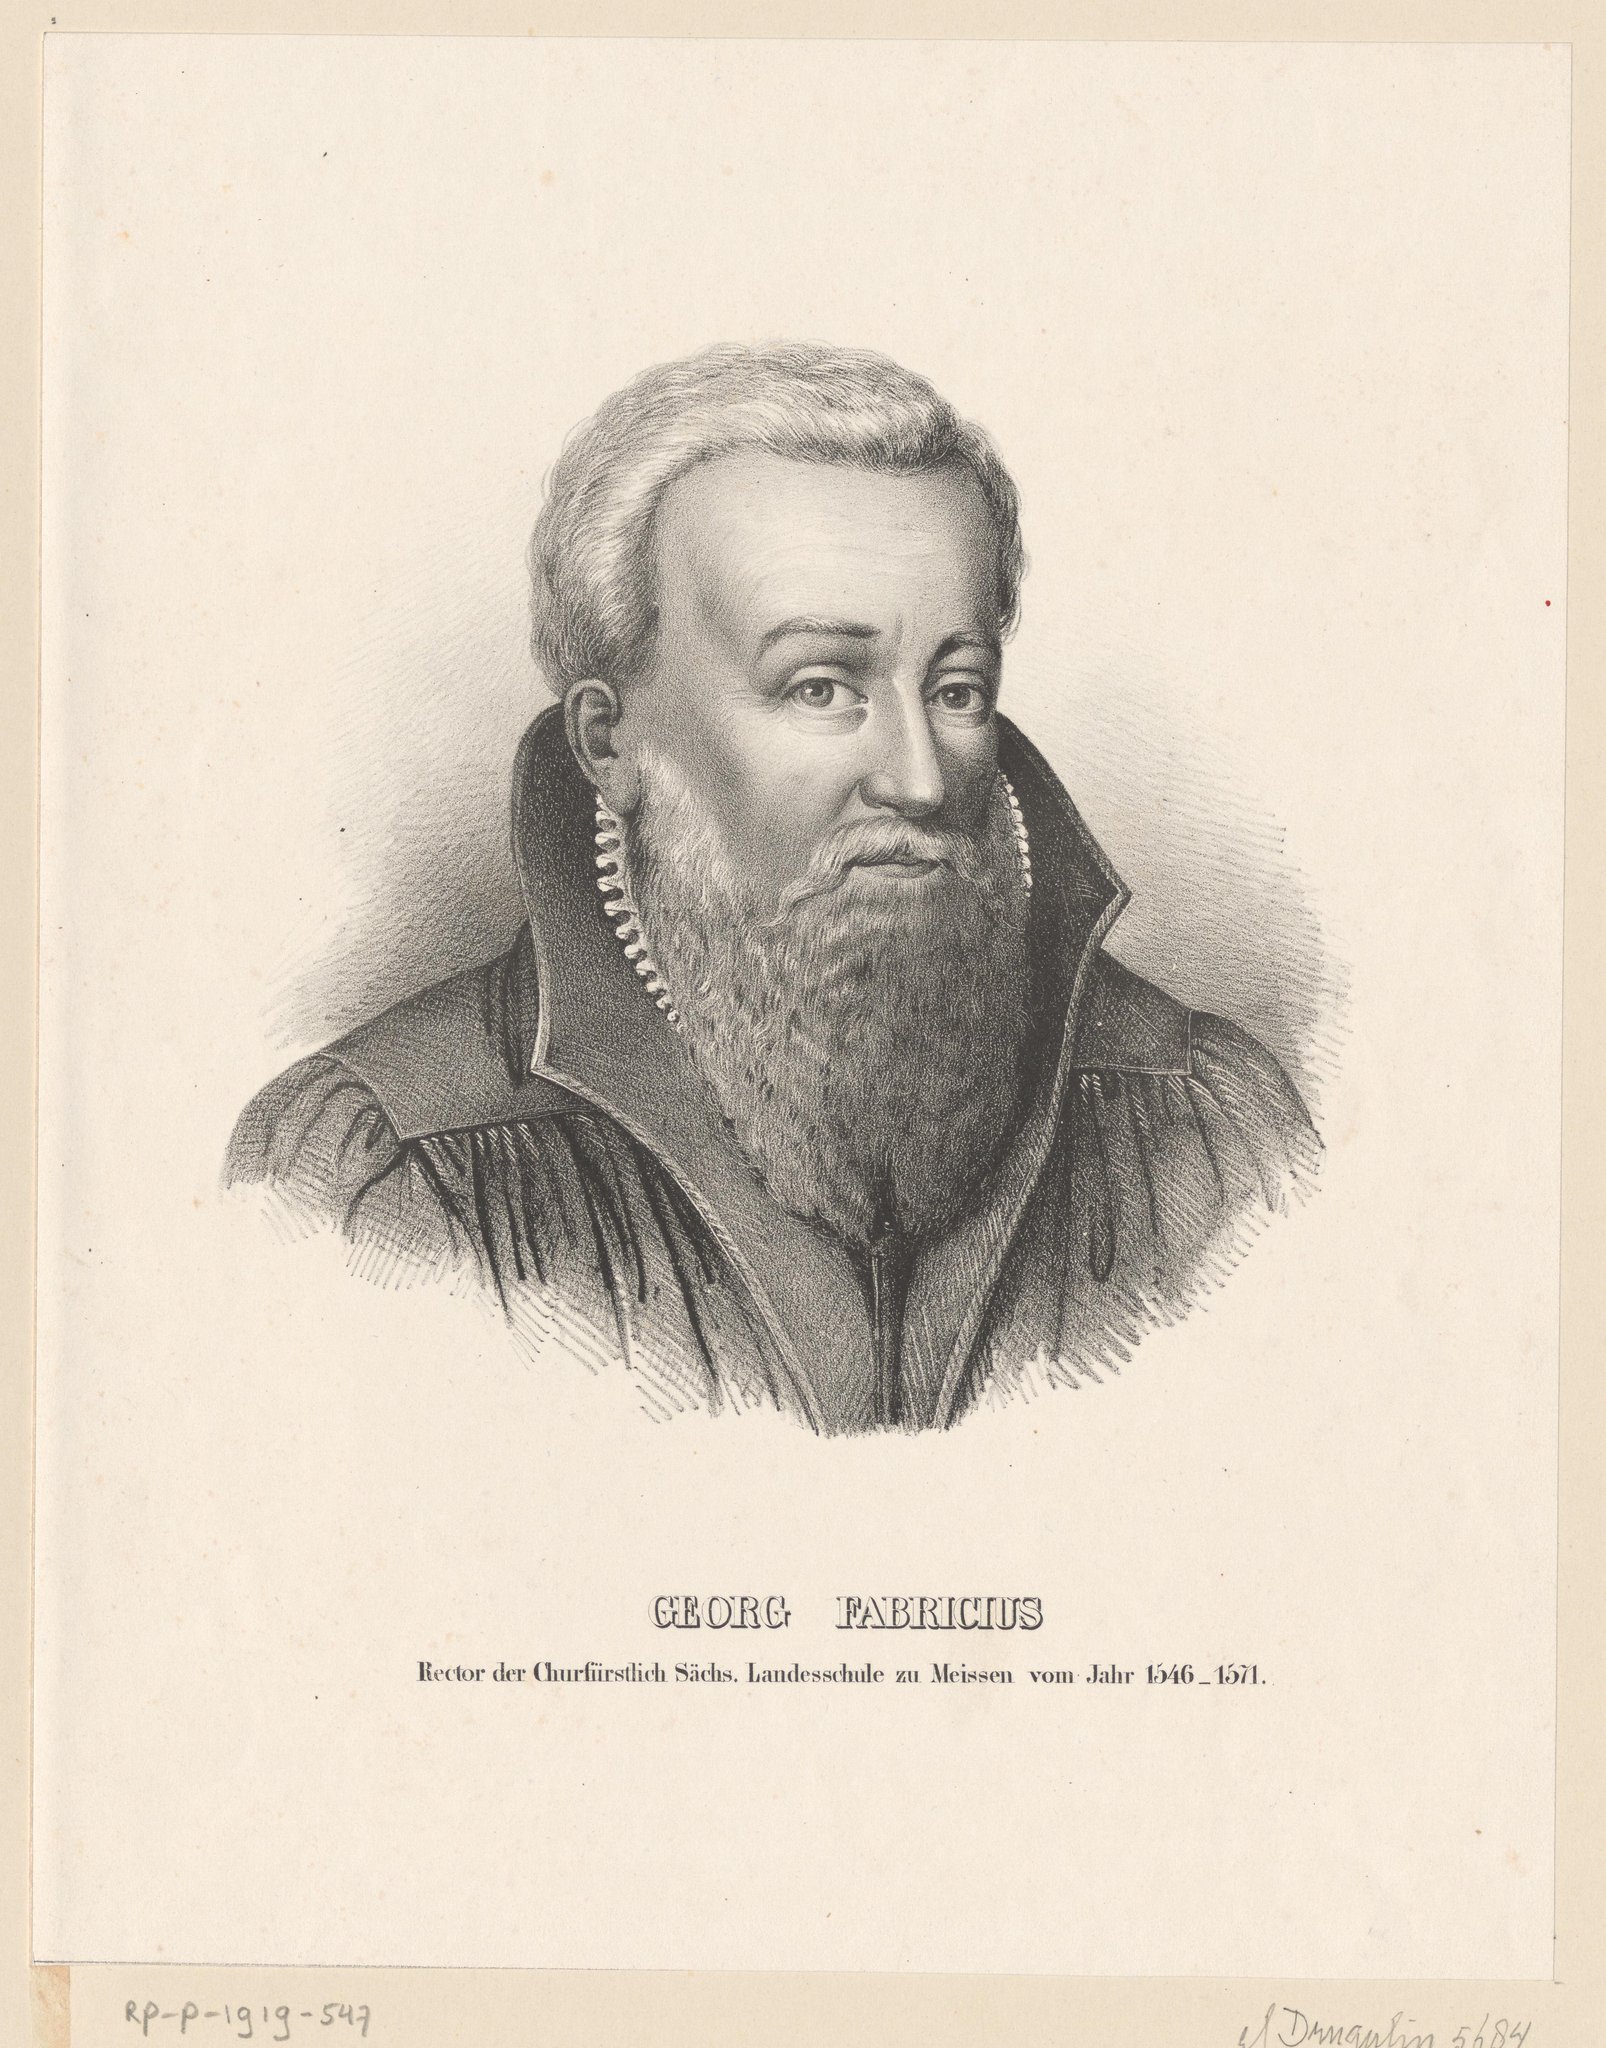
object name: print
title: Portret van Georg Fabricius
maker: Anonymous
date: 1800-1900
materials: paper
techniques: lithograph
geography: germany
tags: chemnitz, georgius fabricius (1516-1571), historical persons, portrait of a writer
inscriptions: collector's mark: Lugt 2228